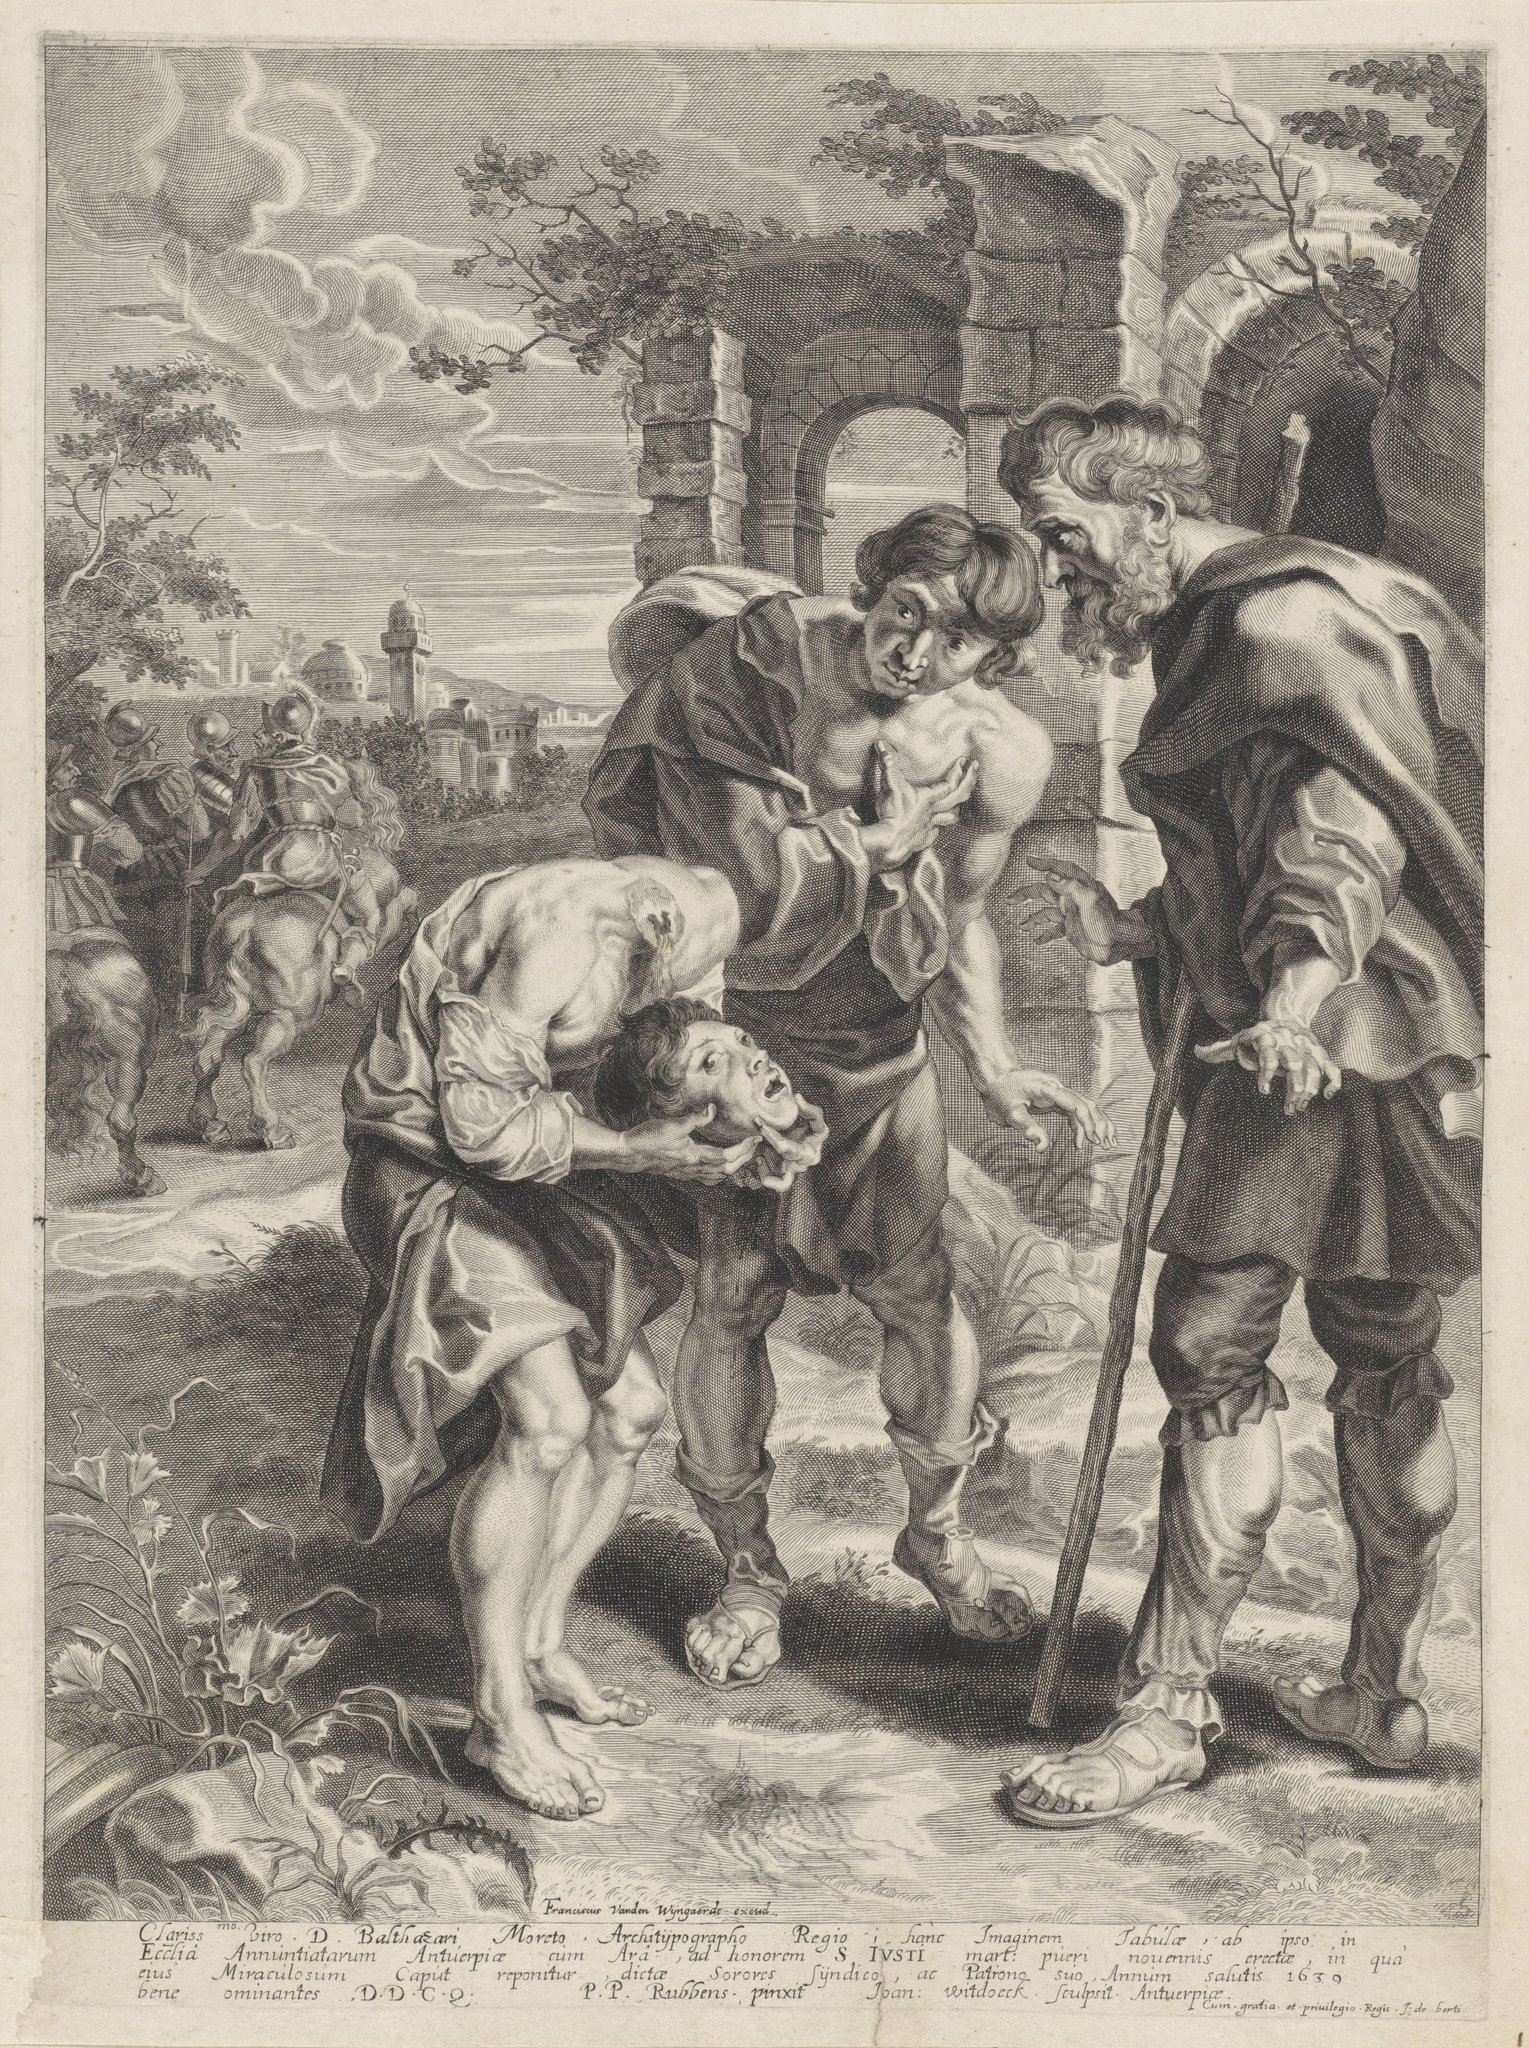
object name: print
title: H. Justus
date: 1639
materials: paper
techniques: engraving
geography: antwerp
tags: st. justus of beauvais as 'cephalophore', carrying his head in his hands after his beheading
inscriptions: collector's mark: Lugt 11, collector's mark: Lugt 10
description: De heilige Justus draagt zijn hoofd na zijn onthoofding.